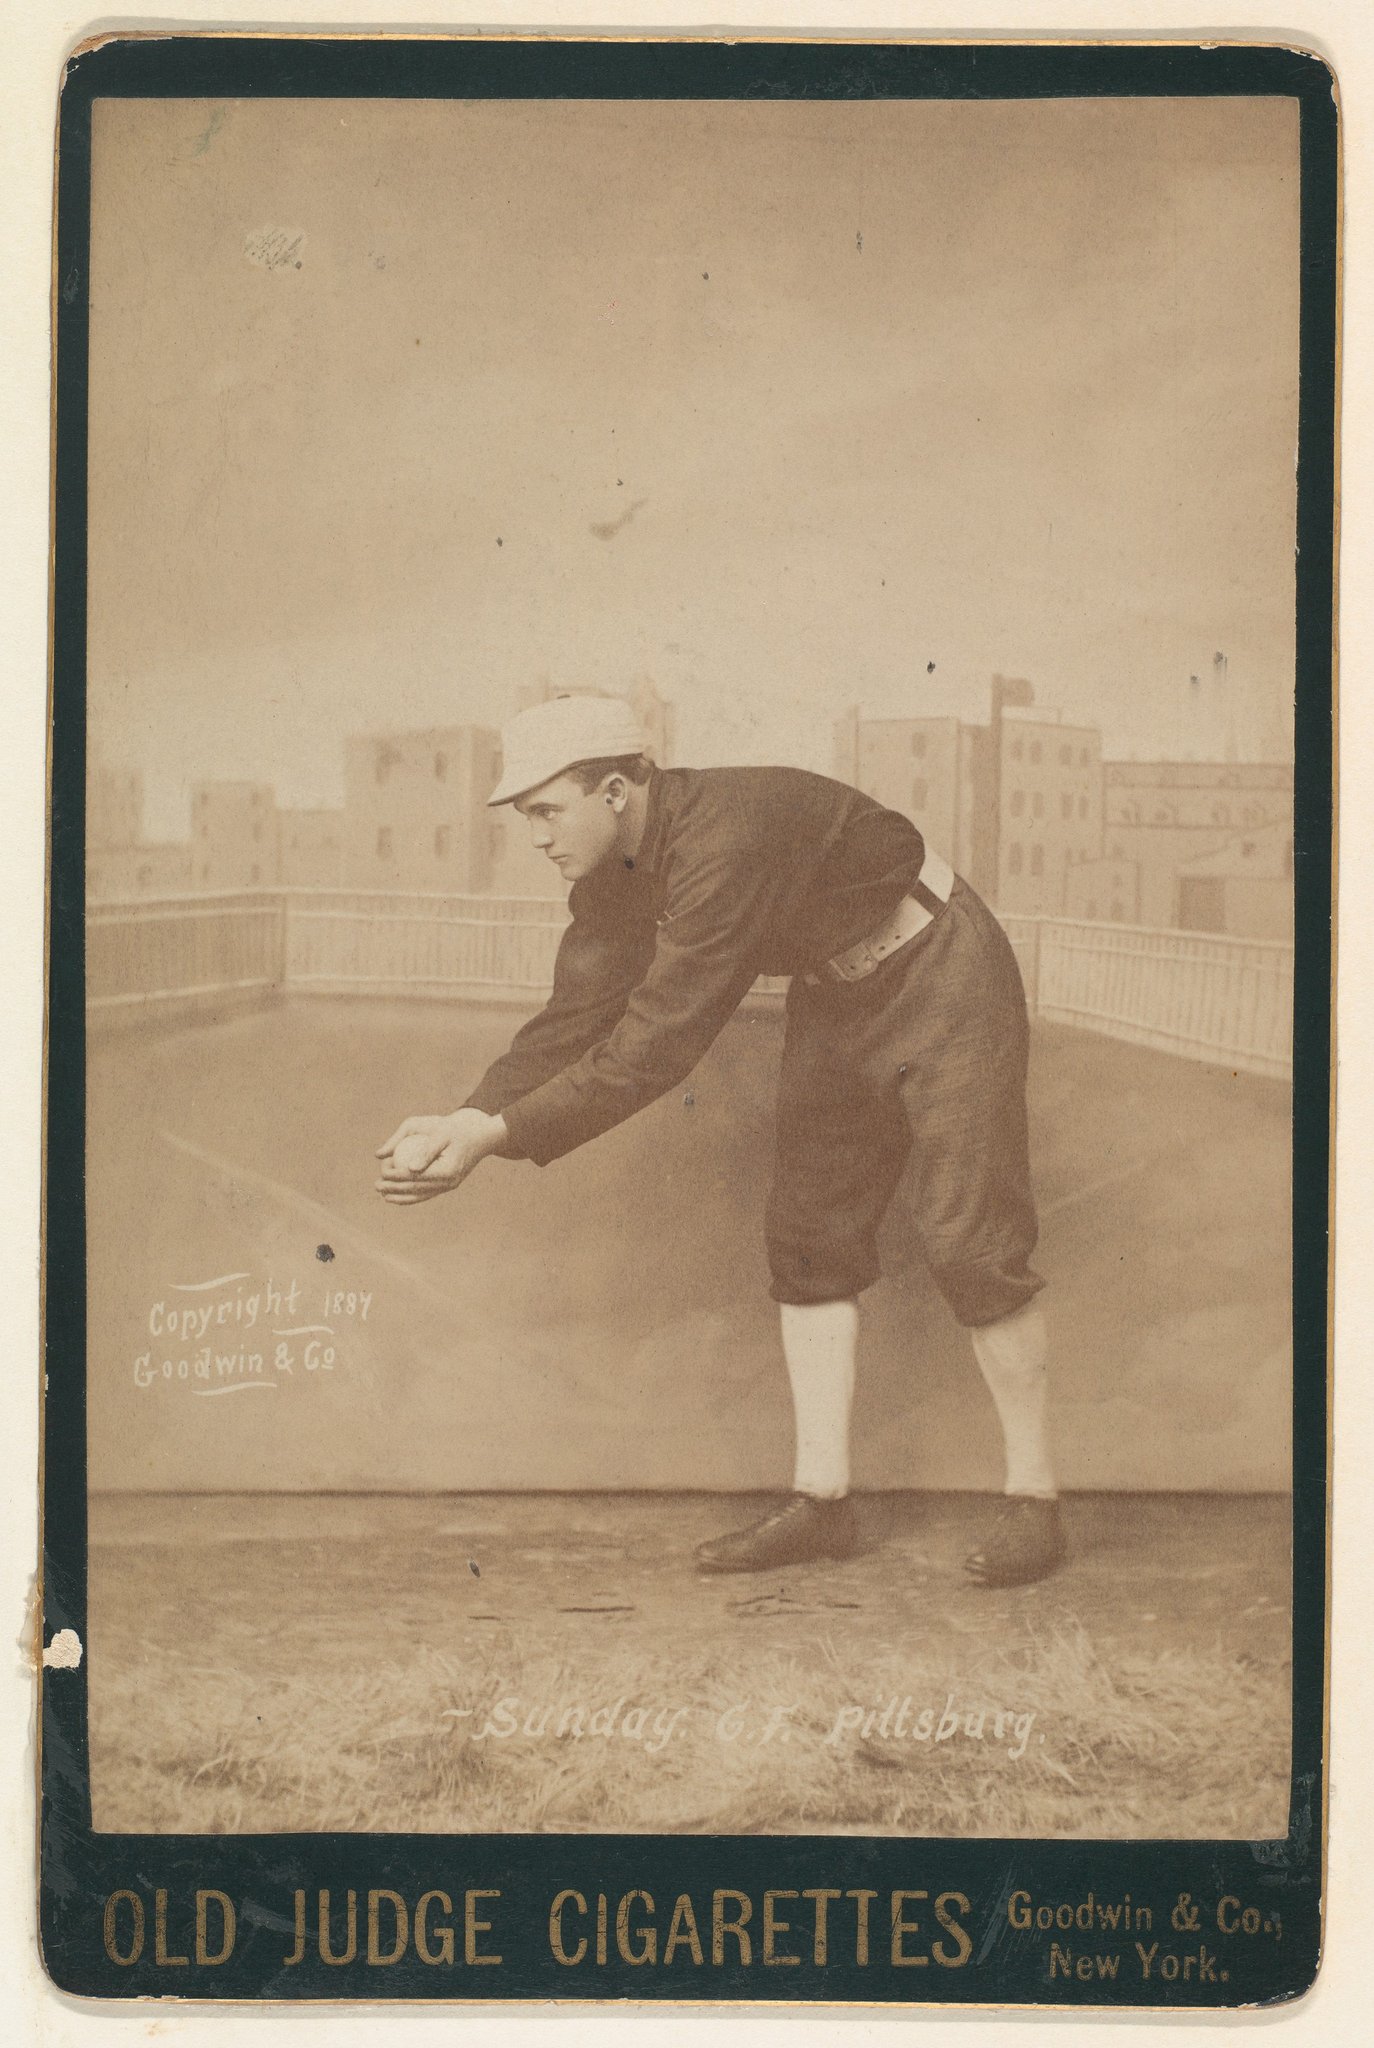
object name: baseball card, photograph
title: Sunday, Center Field, Pittsburgh, from the series Old Judge Cigarettes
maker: goodwin & company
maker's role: publisher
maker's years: 1850-1950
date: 1887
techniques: albumen print, photography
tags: men,portraits,baseball,athletes